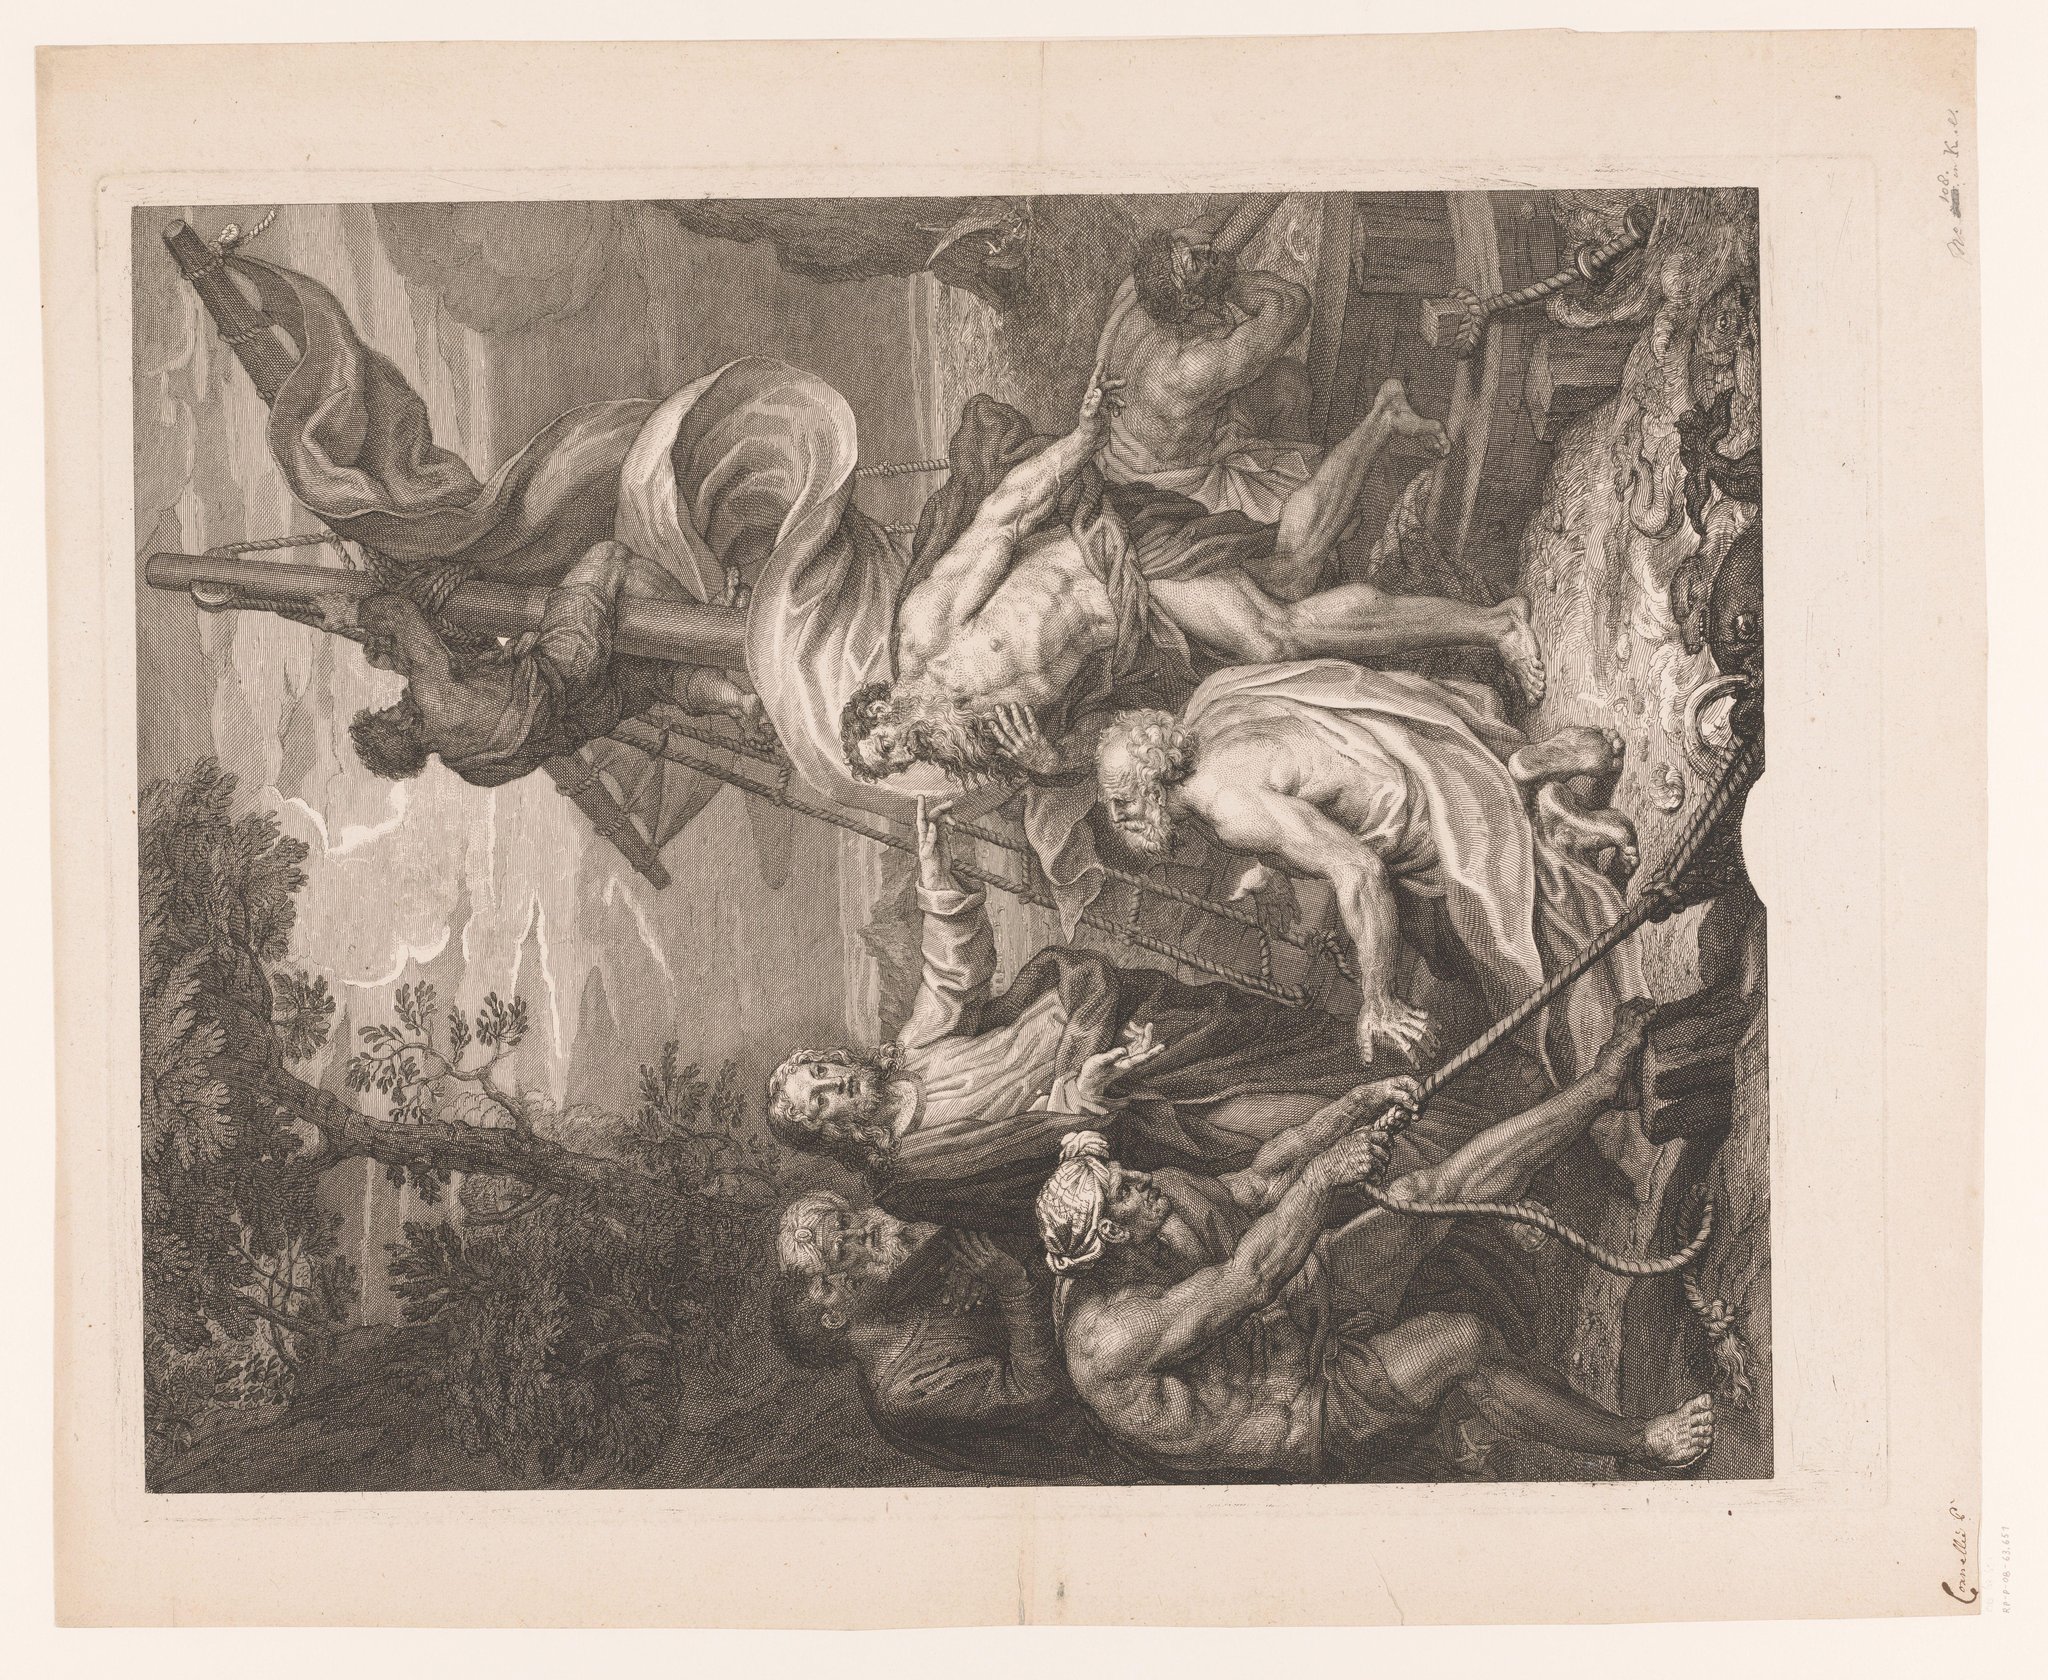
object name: print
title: Christus en miraculeuze visvangst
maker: Anonymous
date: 1650-1750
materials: paper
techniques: engraving, etching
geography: france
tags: christ on the shore, orders the apostles to cast their net to the right side of the boat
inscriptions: collector's mark: Lugt 240, inscription: ‘Corneillie [...]’